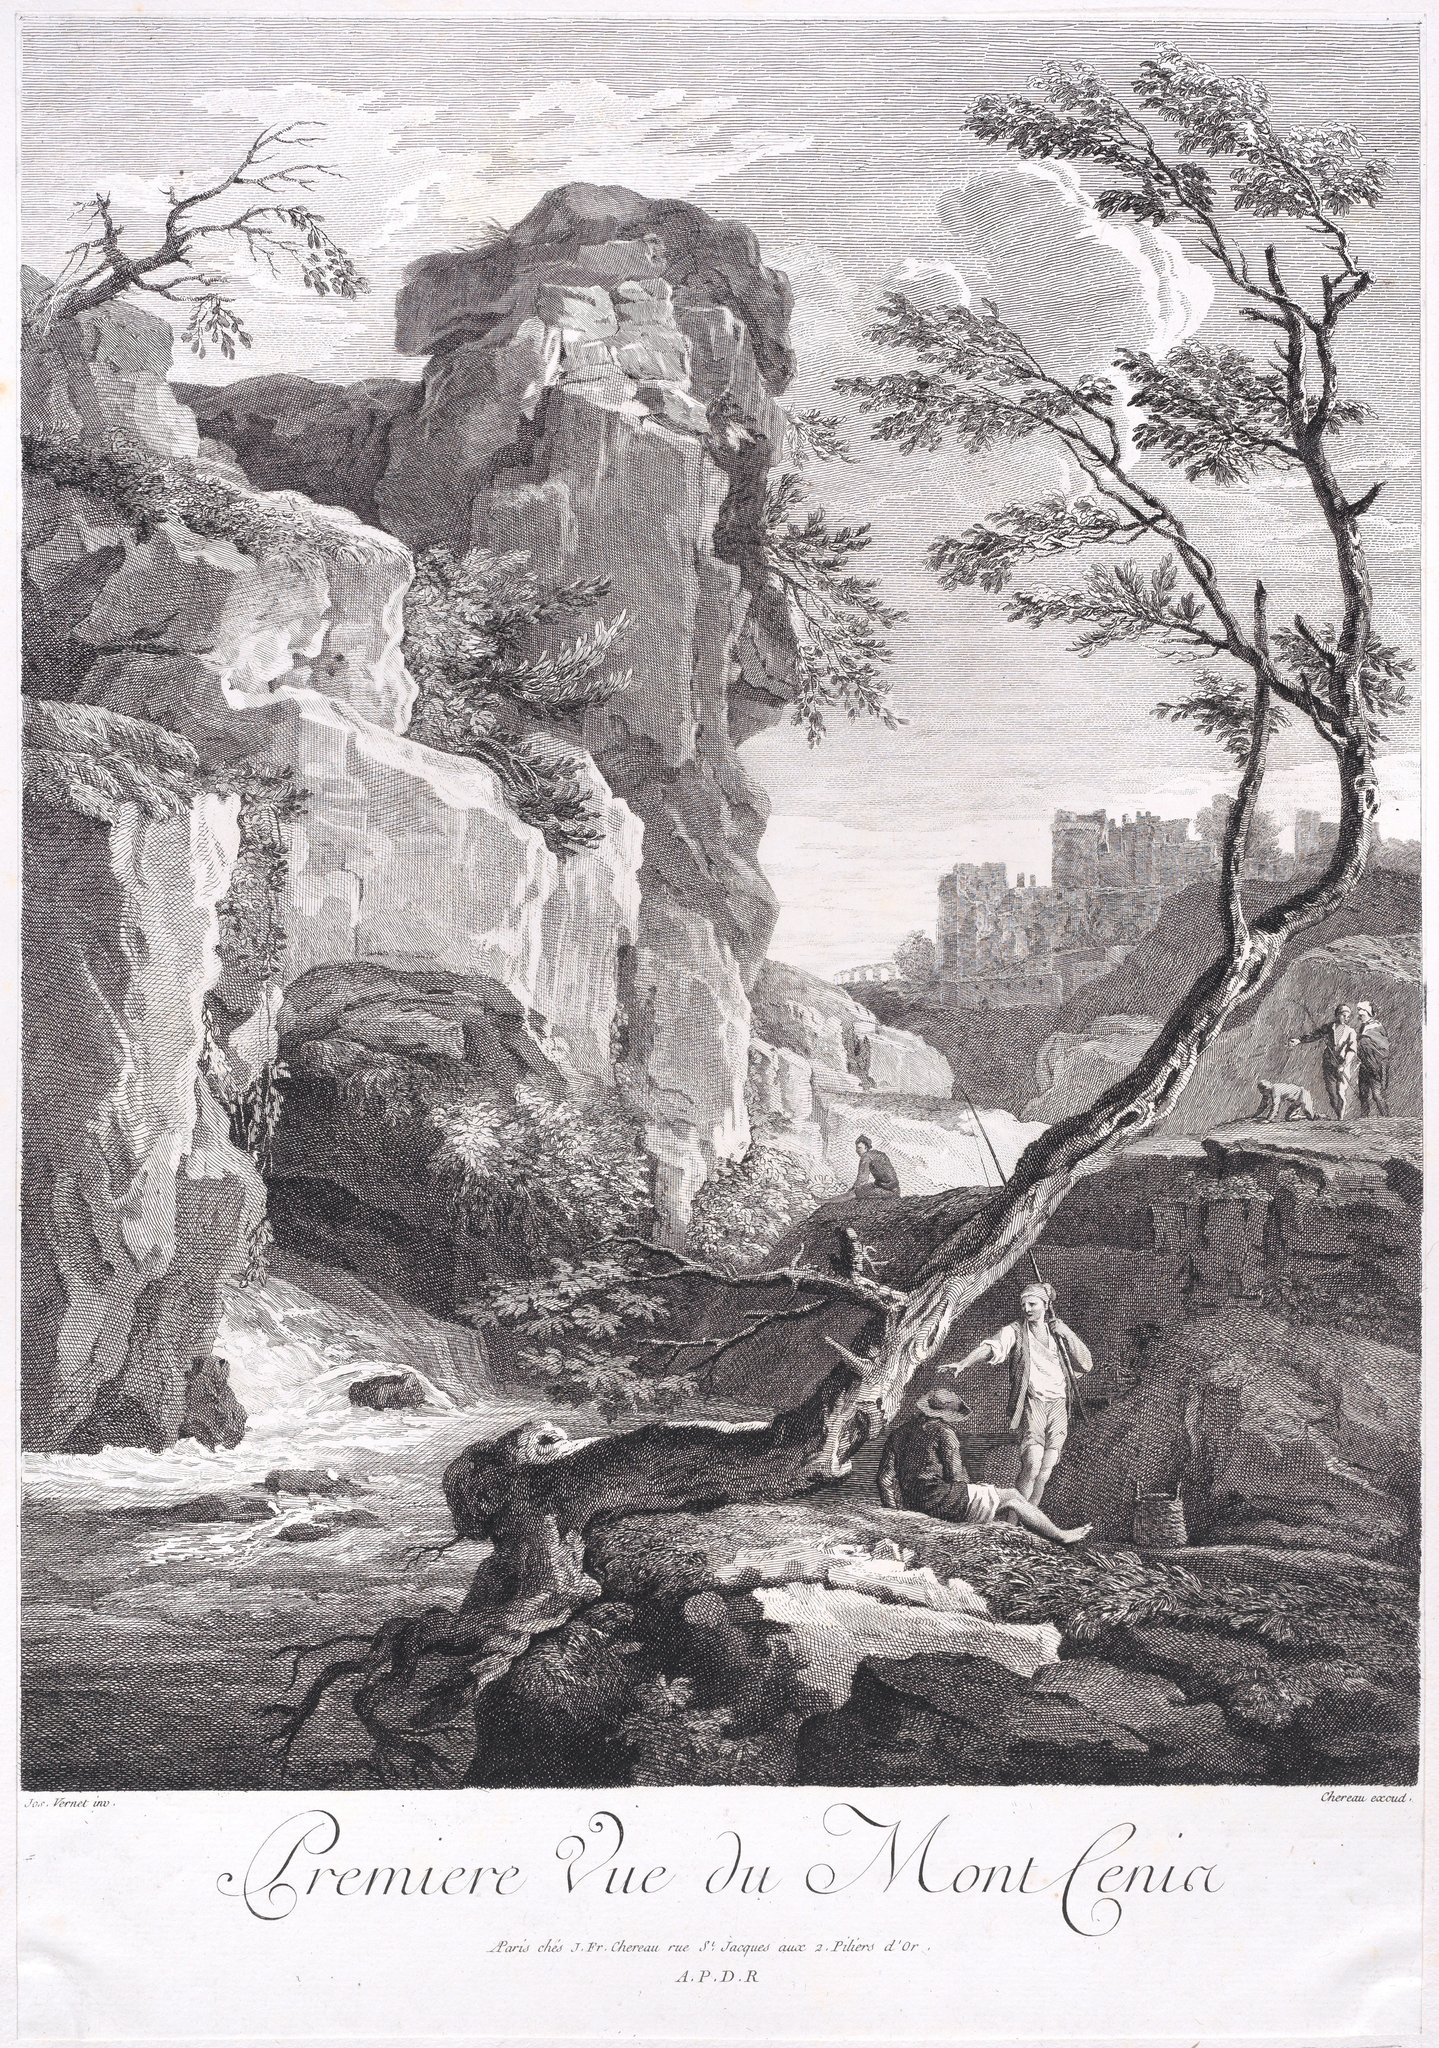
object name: print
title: First View of Mount Cenia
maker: joseph vernet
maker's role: artist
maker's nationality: french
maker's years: 1714-1789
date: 1750-1800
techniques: engraving